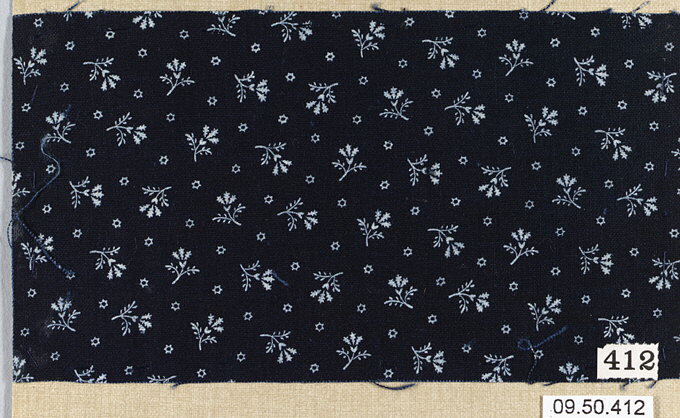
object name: piece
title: Piece (one of 116)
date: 1801-1900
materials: cotton